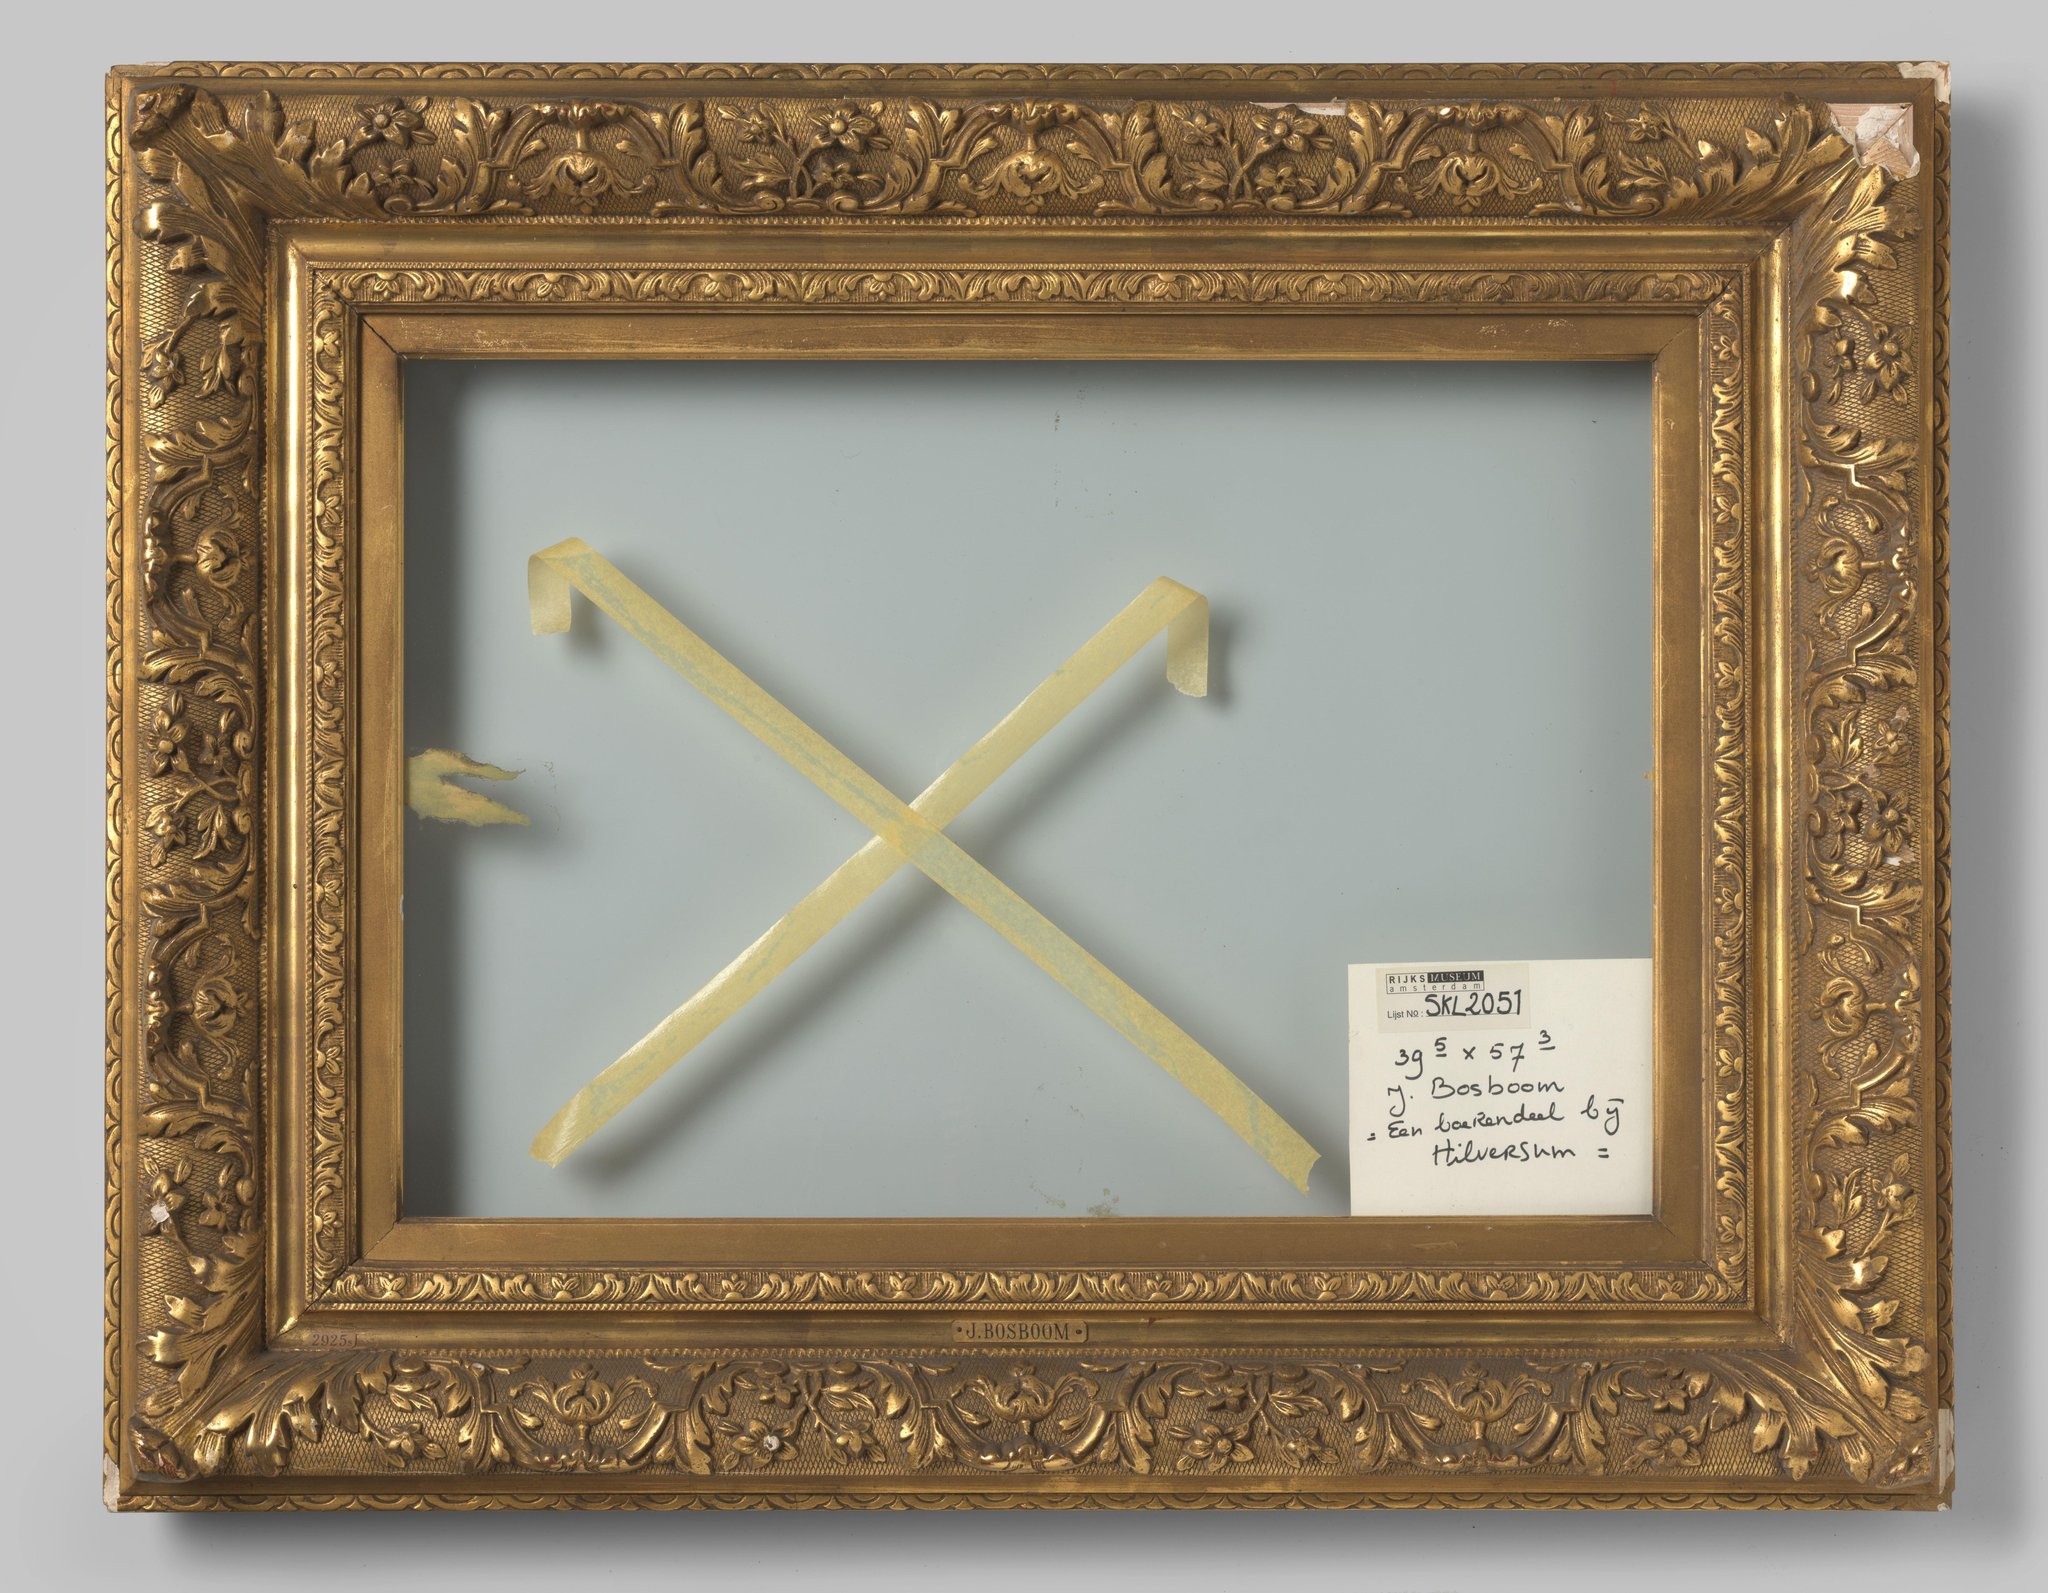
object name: frame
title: Vergulde lijst met pâte-ornamenten in Lodewijk XIII stijl (verenlijst).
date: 1800-1899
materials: gold leaf, wood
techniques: gilding